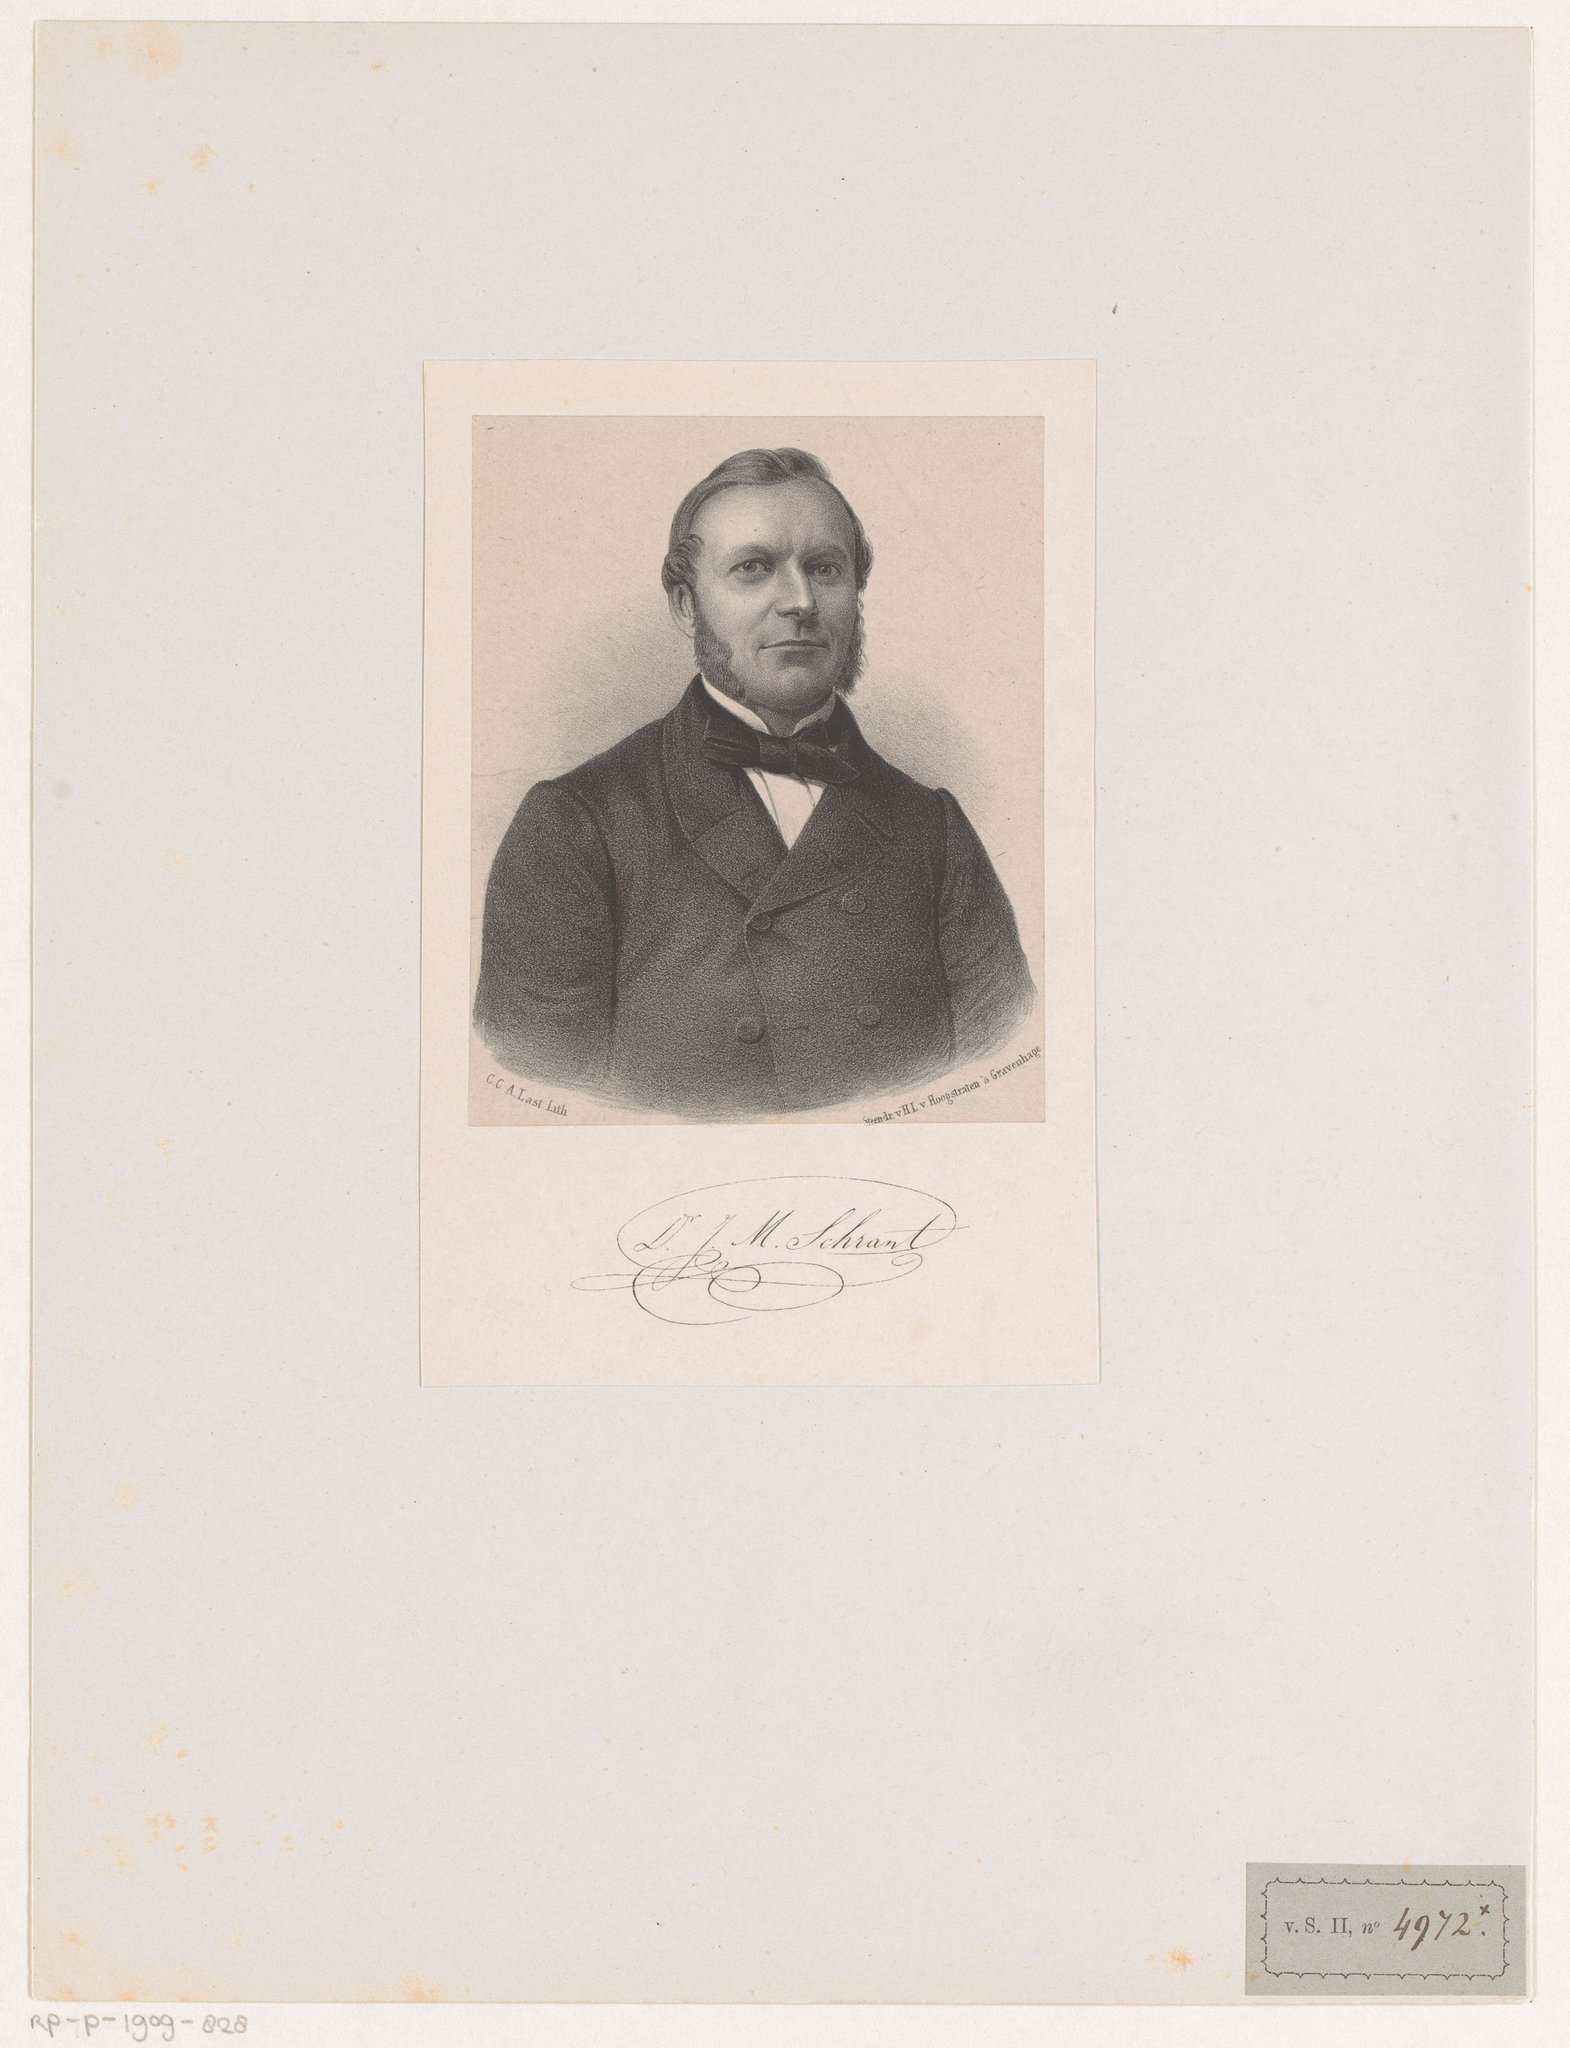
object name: print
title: Portret van Joannes Matthias Schrant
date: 1859-1896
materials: paper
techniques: lithograph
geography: the hague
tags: the hague, leiden, historical persons (+ (full) bust portrait)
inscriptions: collector's mark: Lugt 2228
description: Onder het portret de signatuur van de geportretteerde.